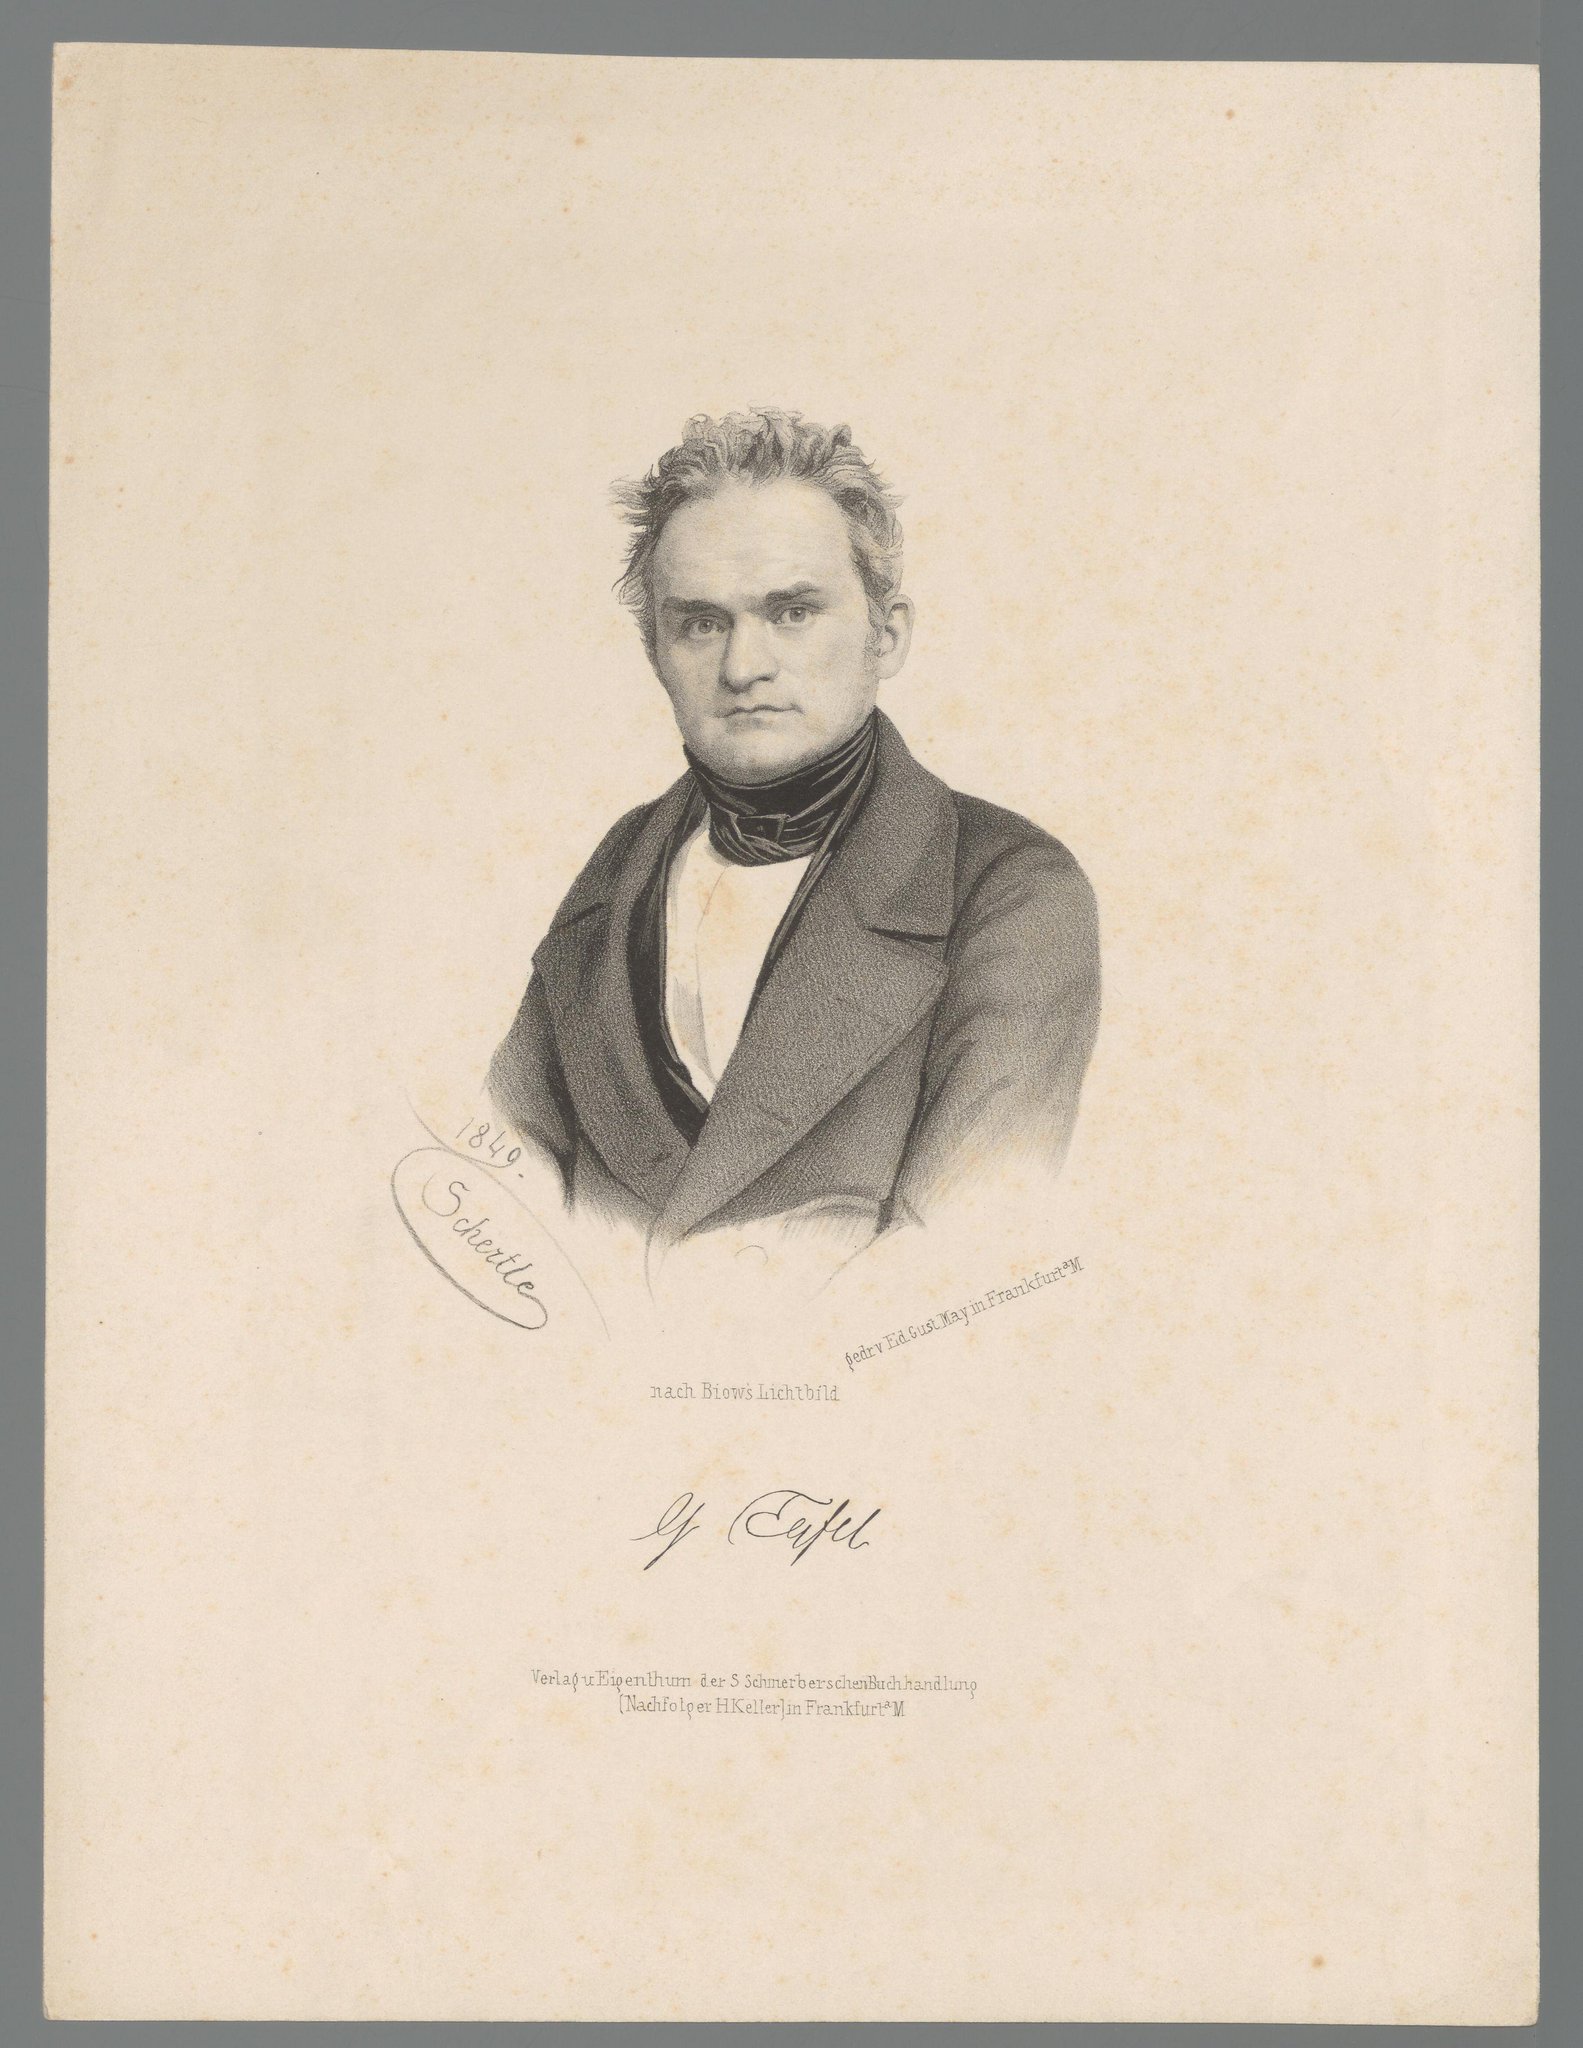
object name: print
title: Die Männer des deutschen Volks, besonders nach Biows Lichtbildern auf Stein gezeichnet von Schertle und Hickmann, oder Deutsche National-Gallerie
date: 1849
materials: paper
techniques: lithograph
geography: frankfurt am main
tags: politician, adult man, historical persons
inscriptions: collector's mark: Lugt 2228